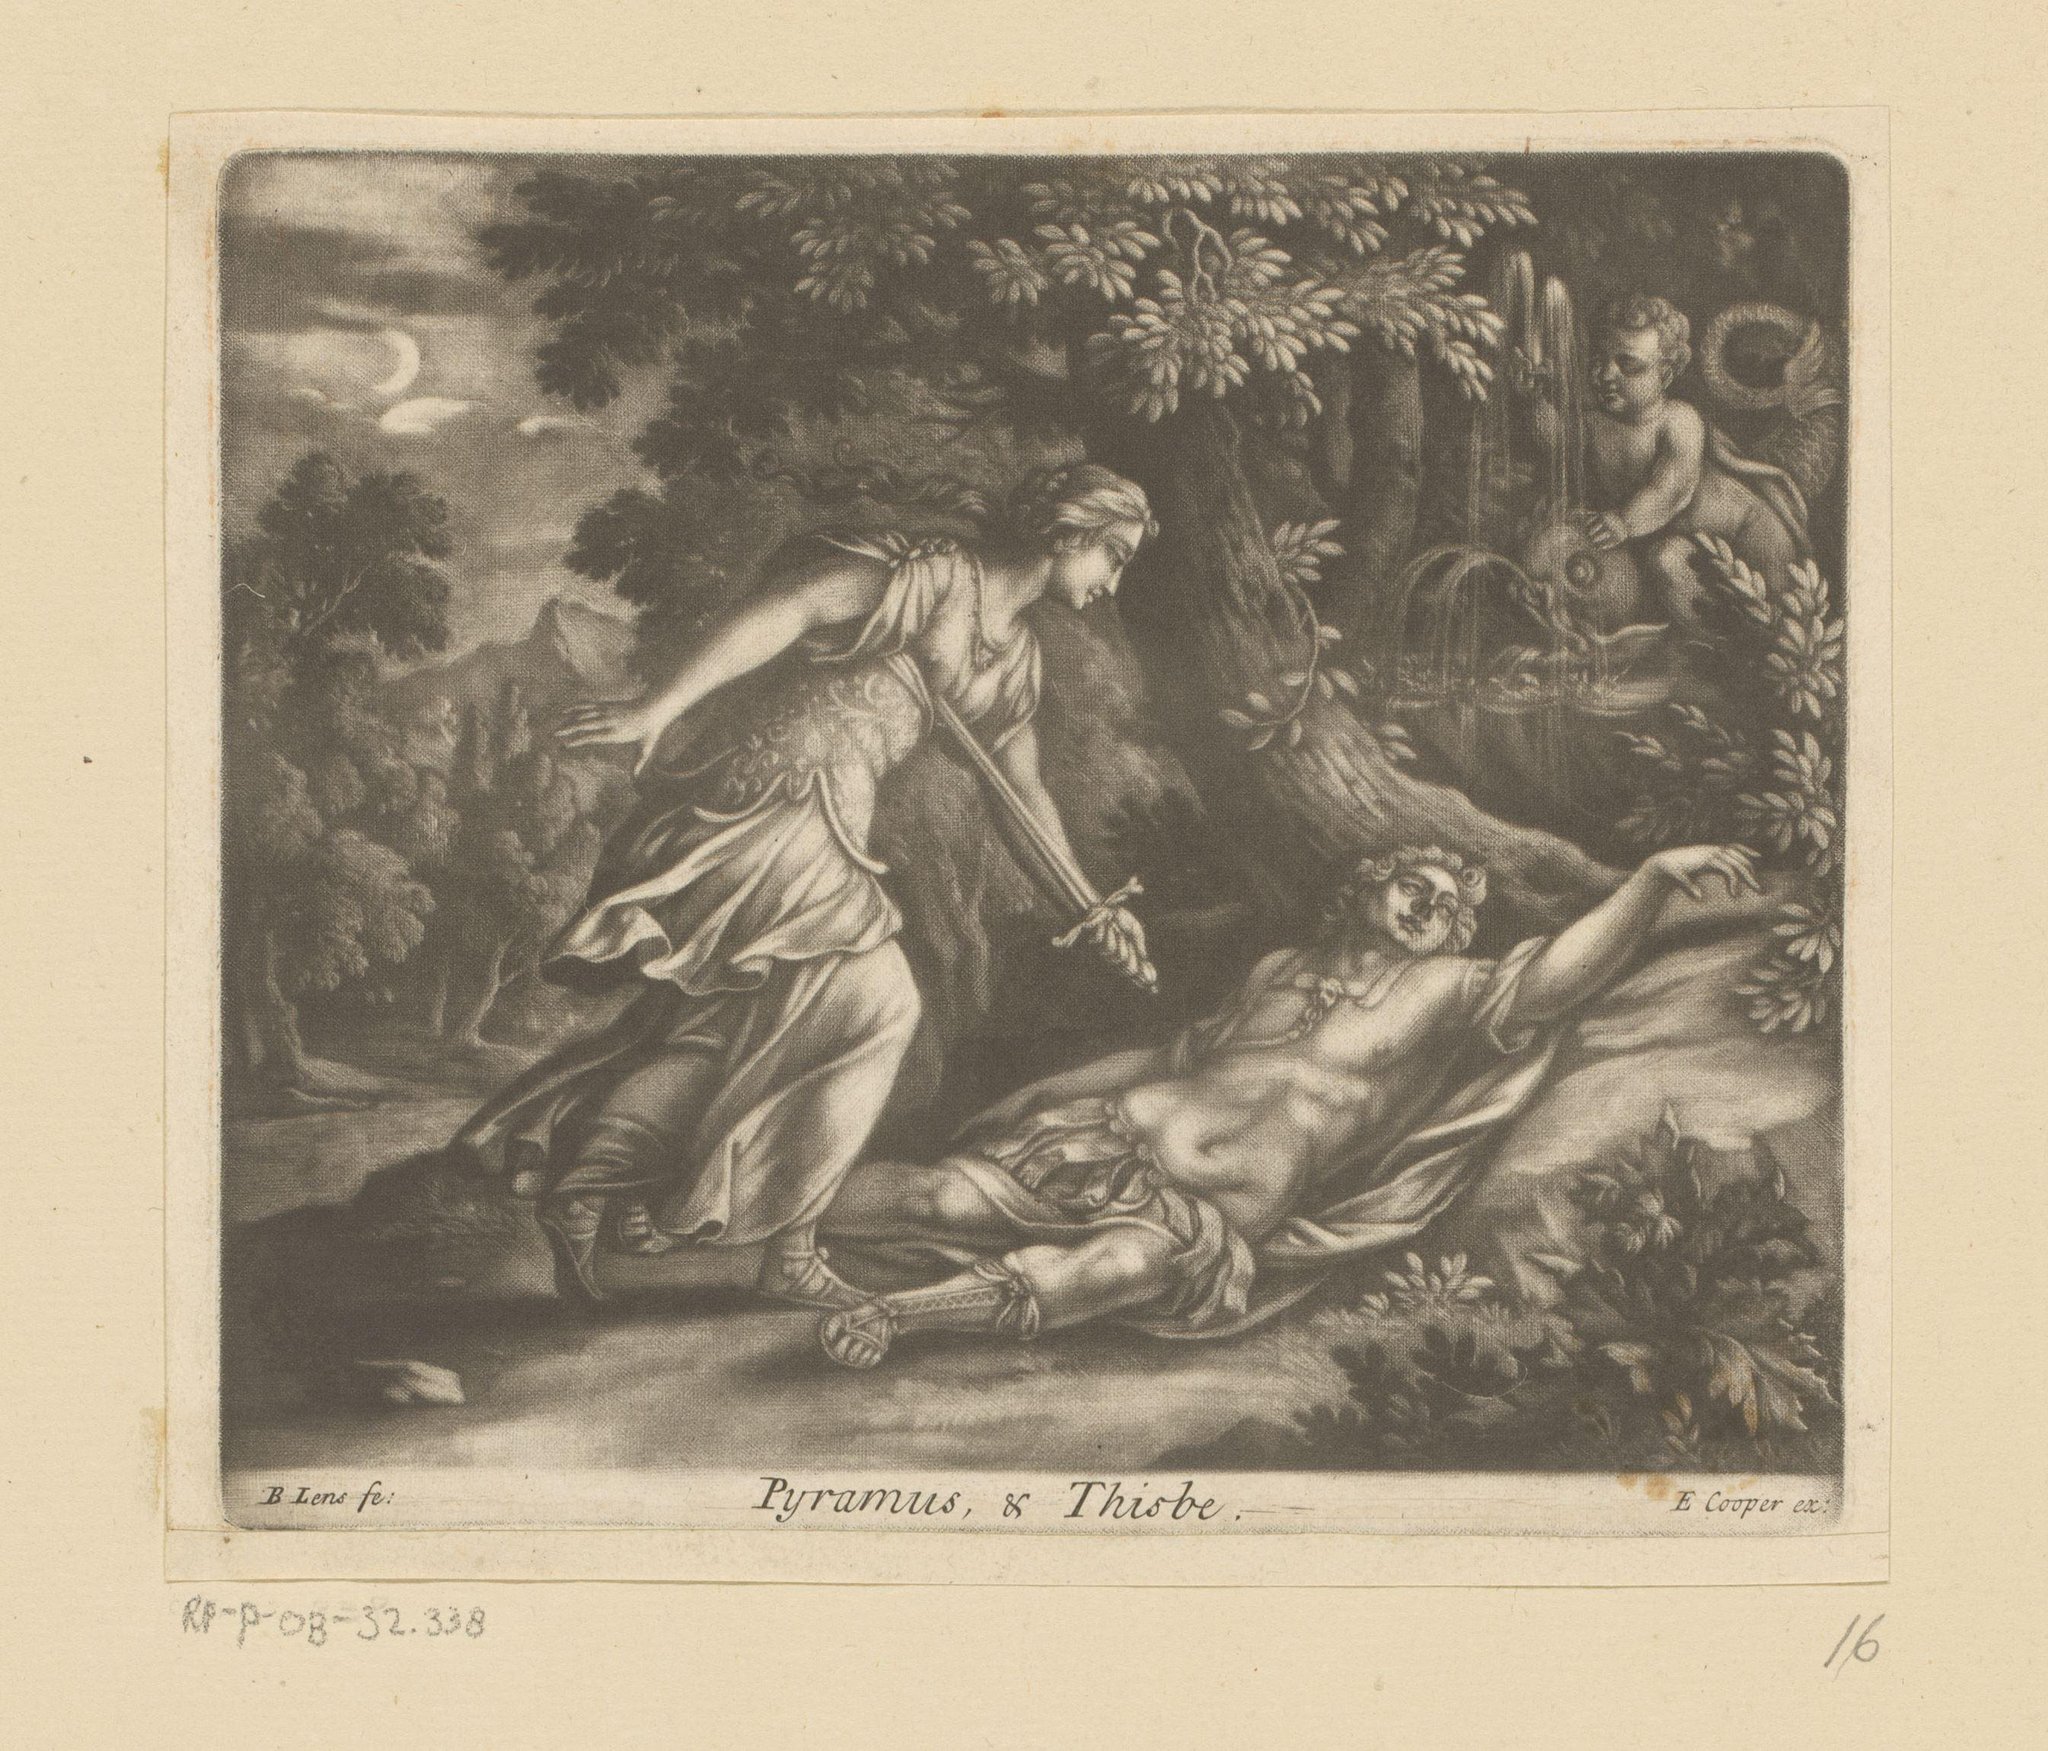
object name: print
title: Thisbe doodt zichzelf met het zwaard van Pyramus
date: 1682-1725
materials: paper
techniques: etching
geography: london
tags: thisbe kills herself with pyramus' sword (the scene may be represented near a fountain)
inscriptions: collector's mark: Lugt 240